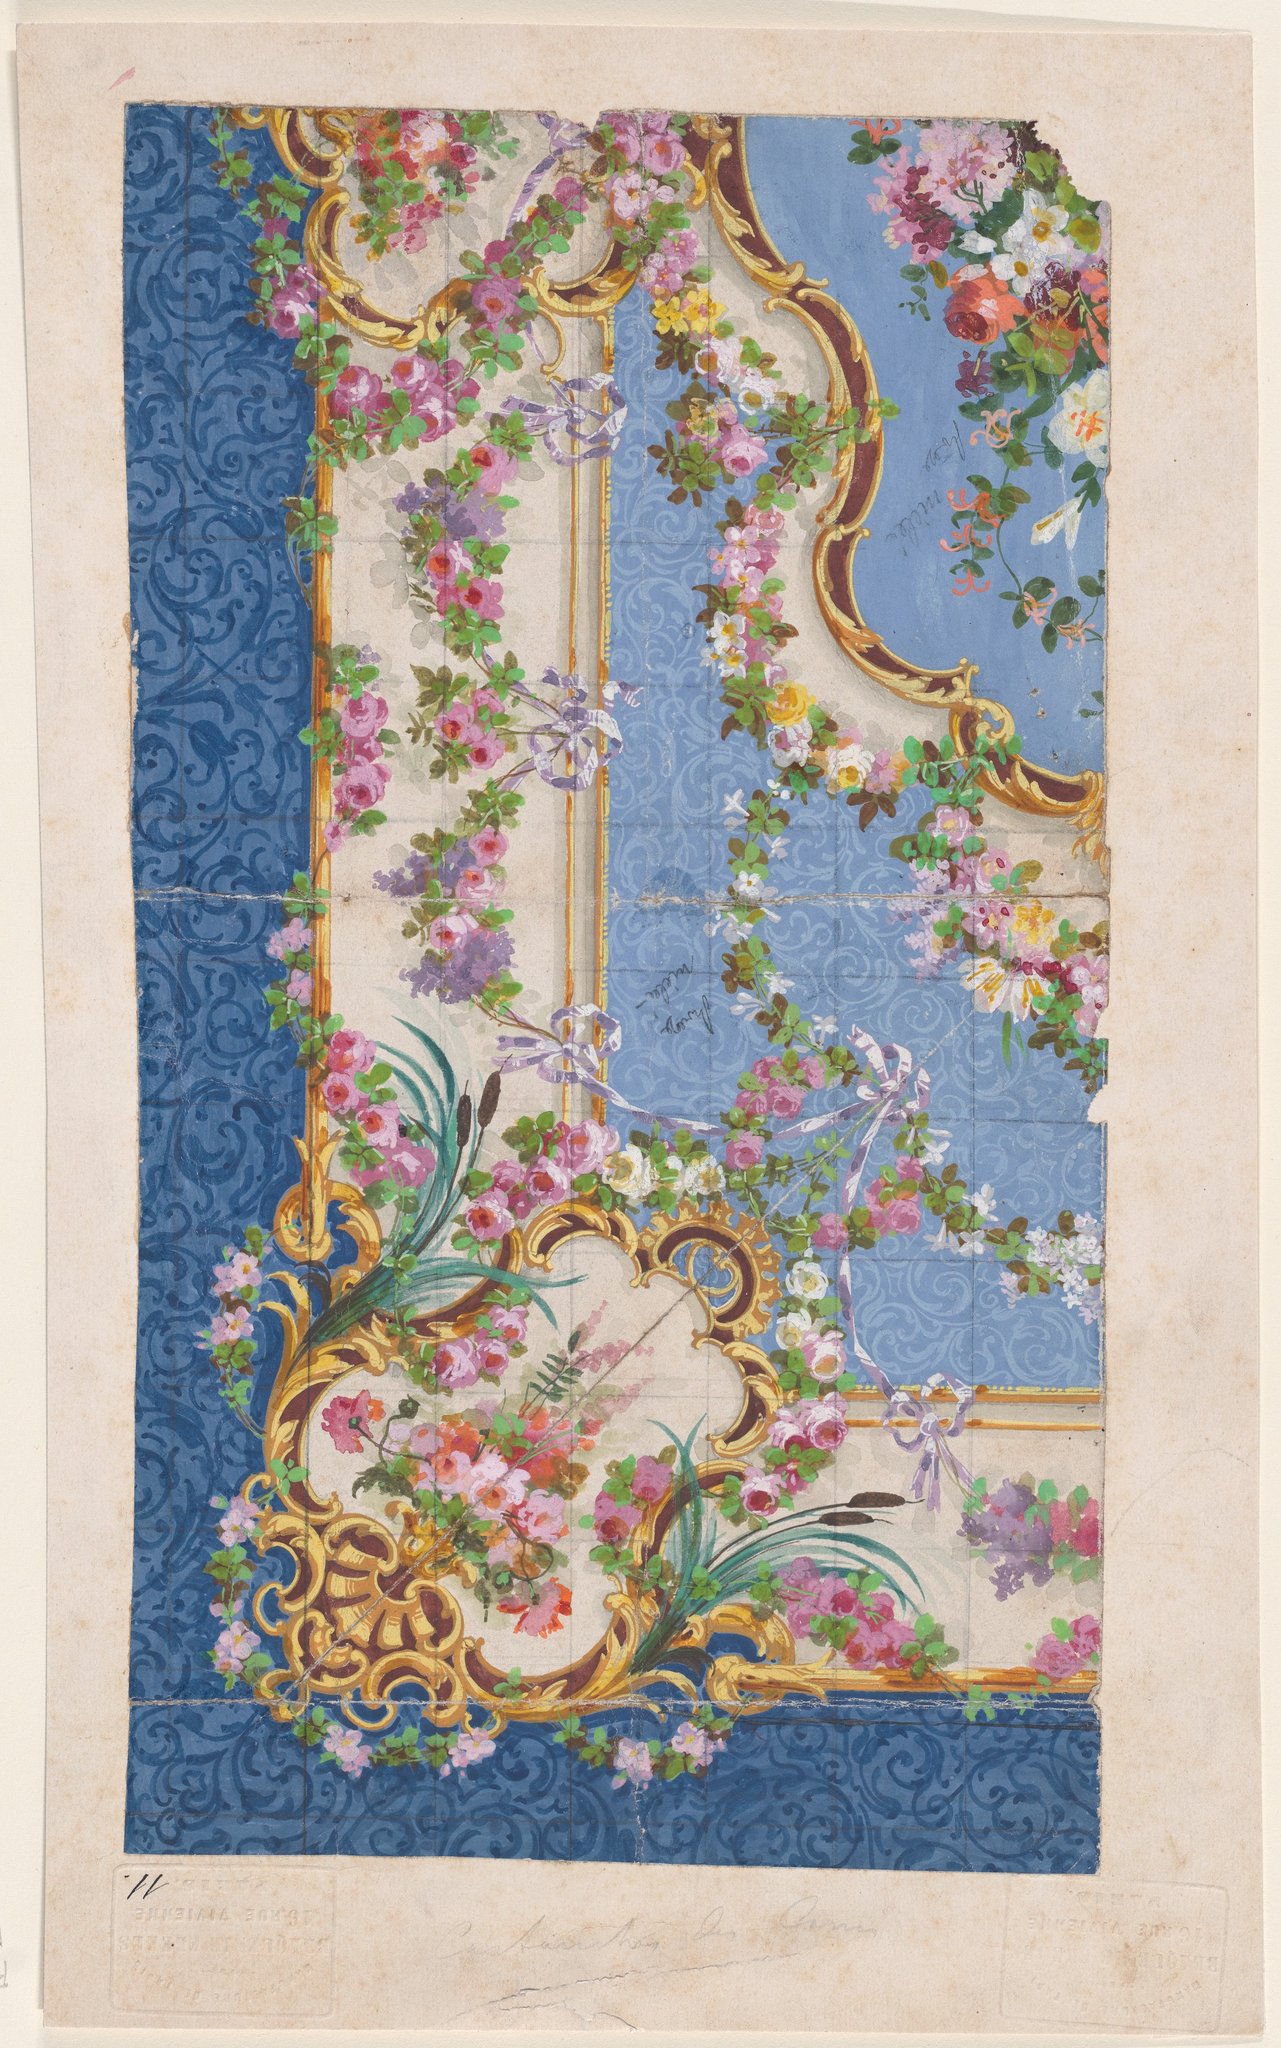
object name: drawing ornament architecture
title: Design for a Rug with Ornamental Frames and Garlands and Festoons of Leaves, Flowers, and Ribbons Over a Background of Arabesques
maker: braquenié et cie.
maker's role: design house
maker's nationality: french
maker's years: 1858-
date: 1858-1900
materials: gouache